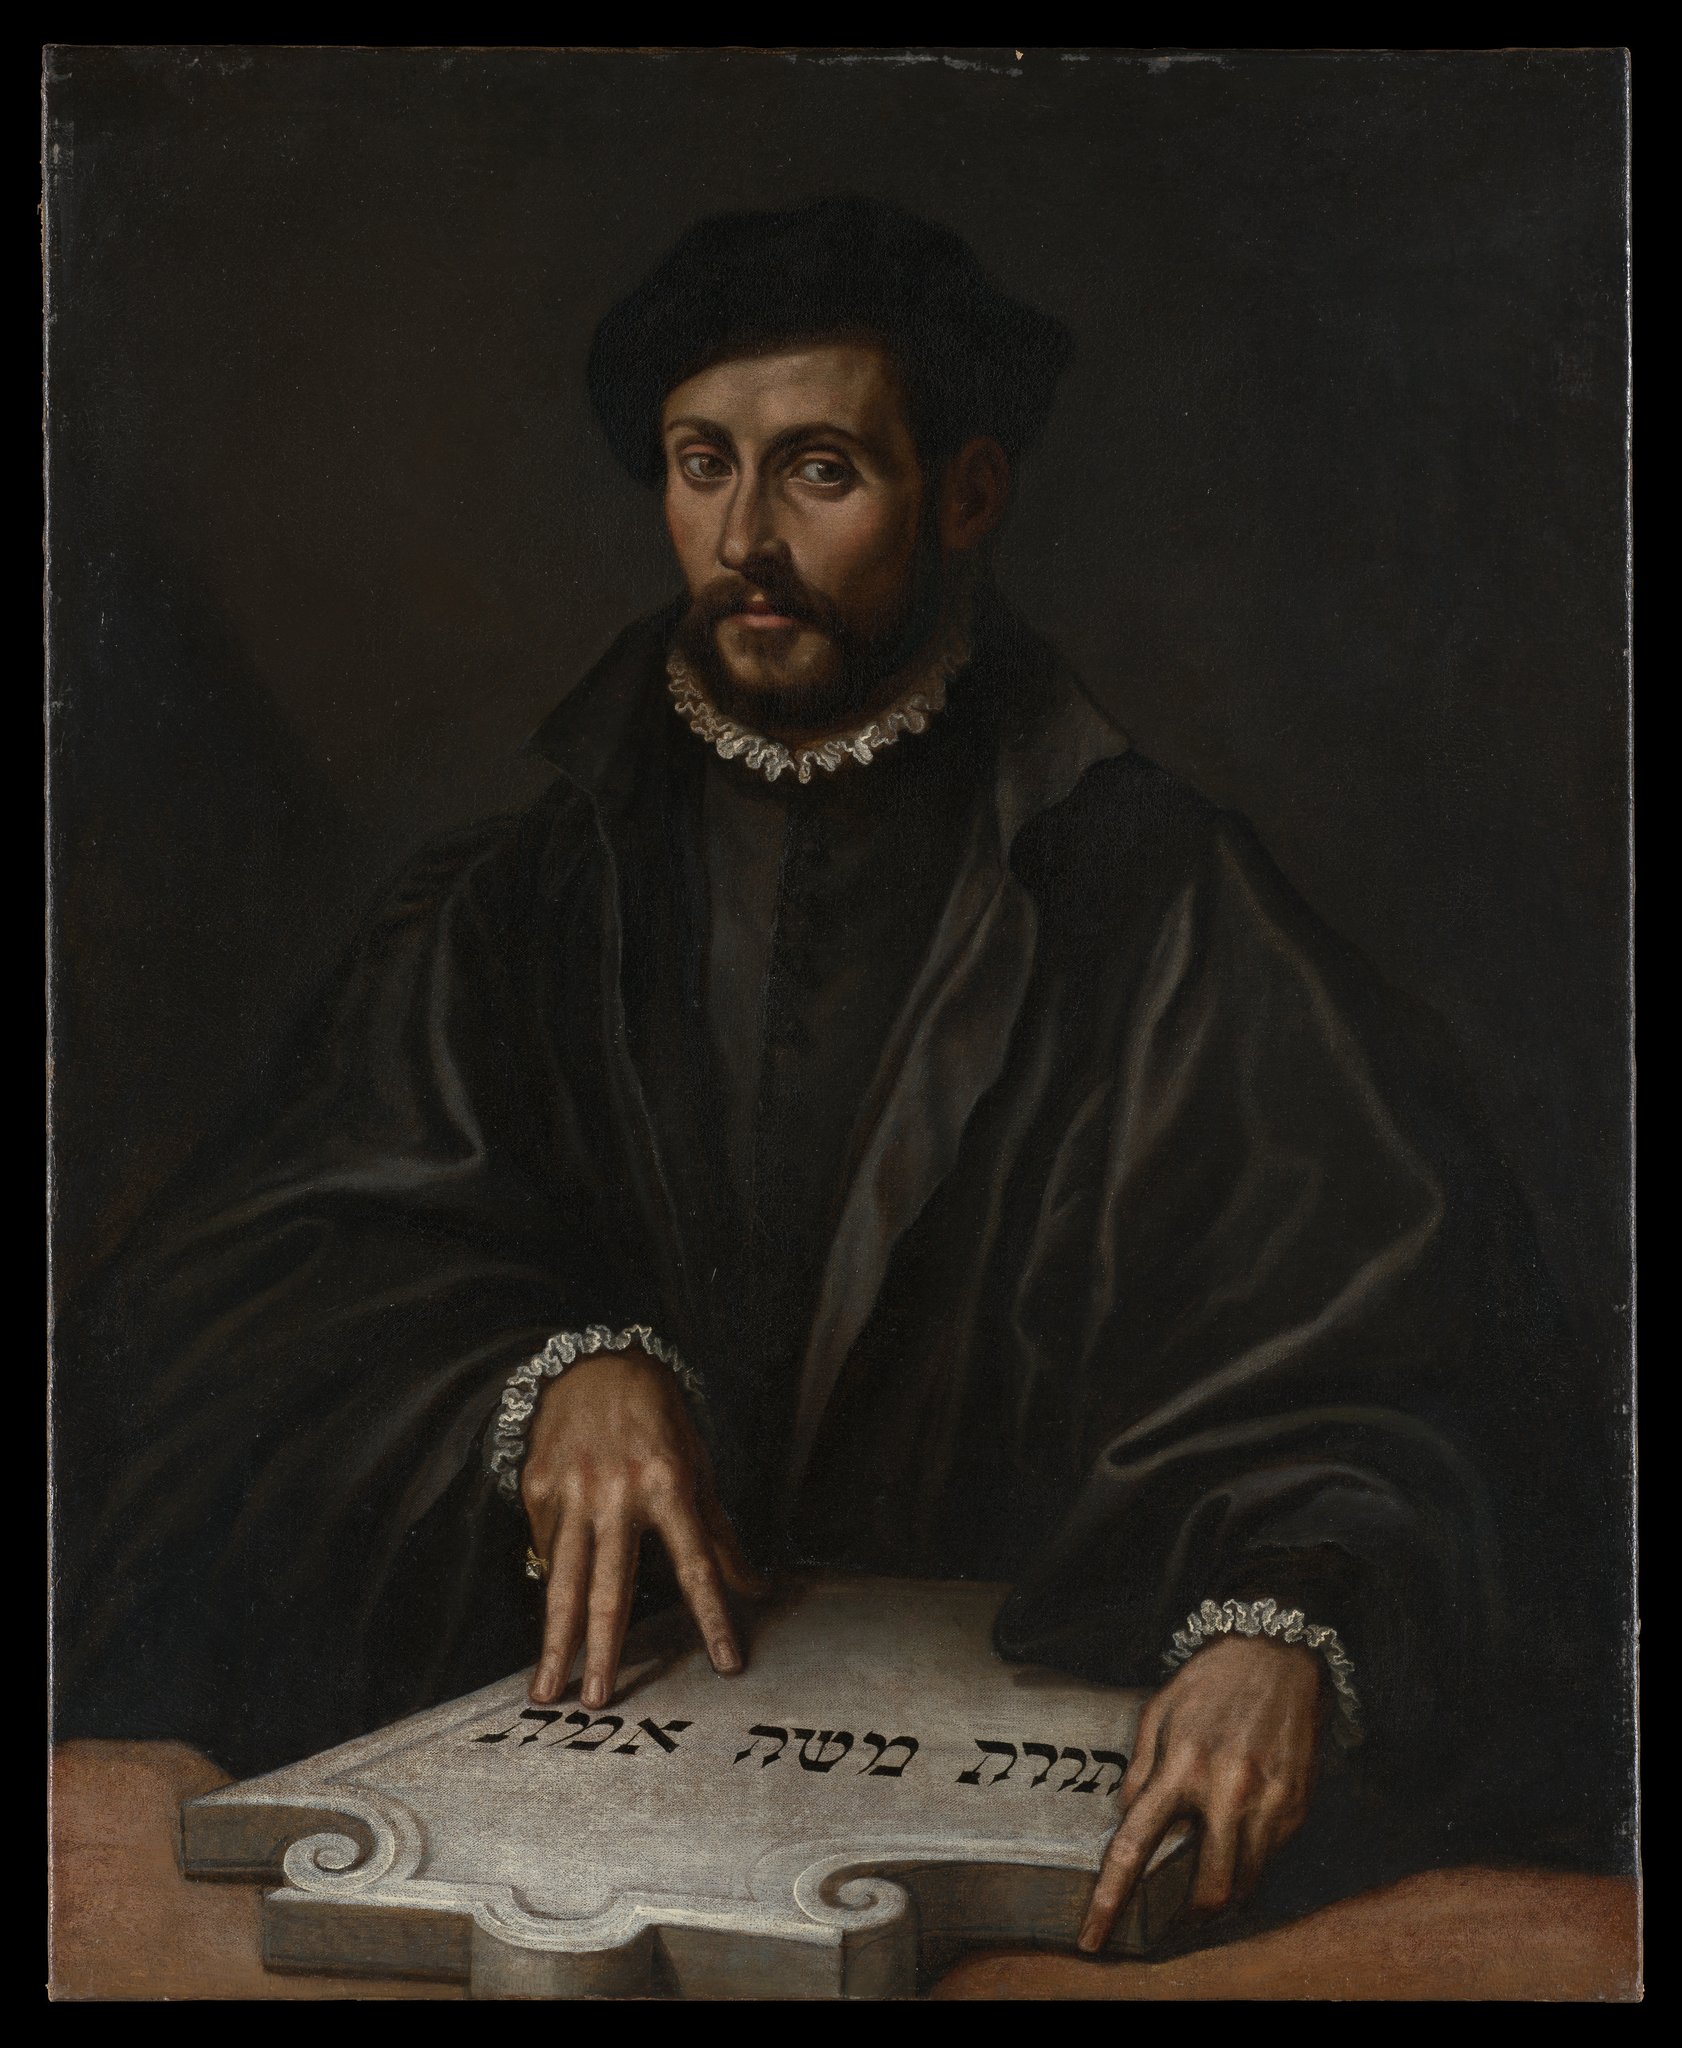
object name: painting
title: Portrait of a Man with a Hebrew Tablet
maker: antonio campi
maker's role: artist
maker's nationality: italian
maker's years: 1523-1587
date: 1575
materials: canvas, oil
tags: men,portraits